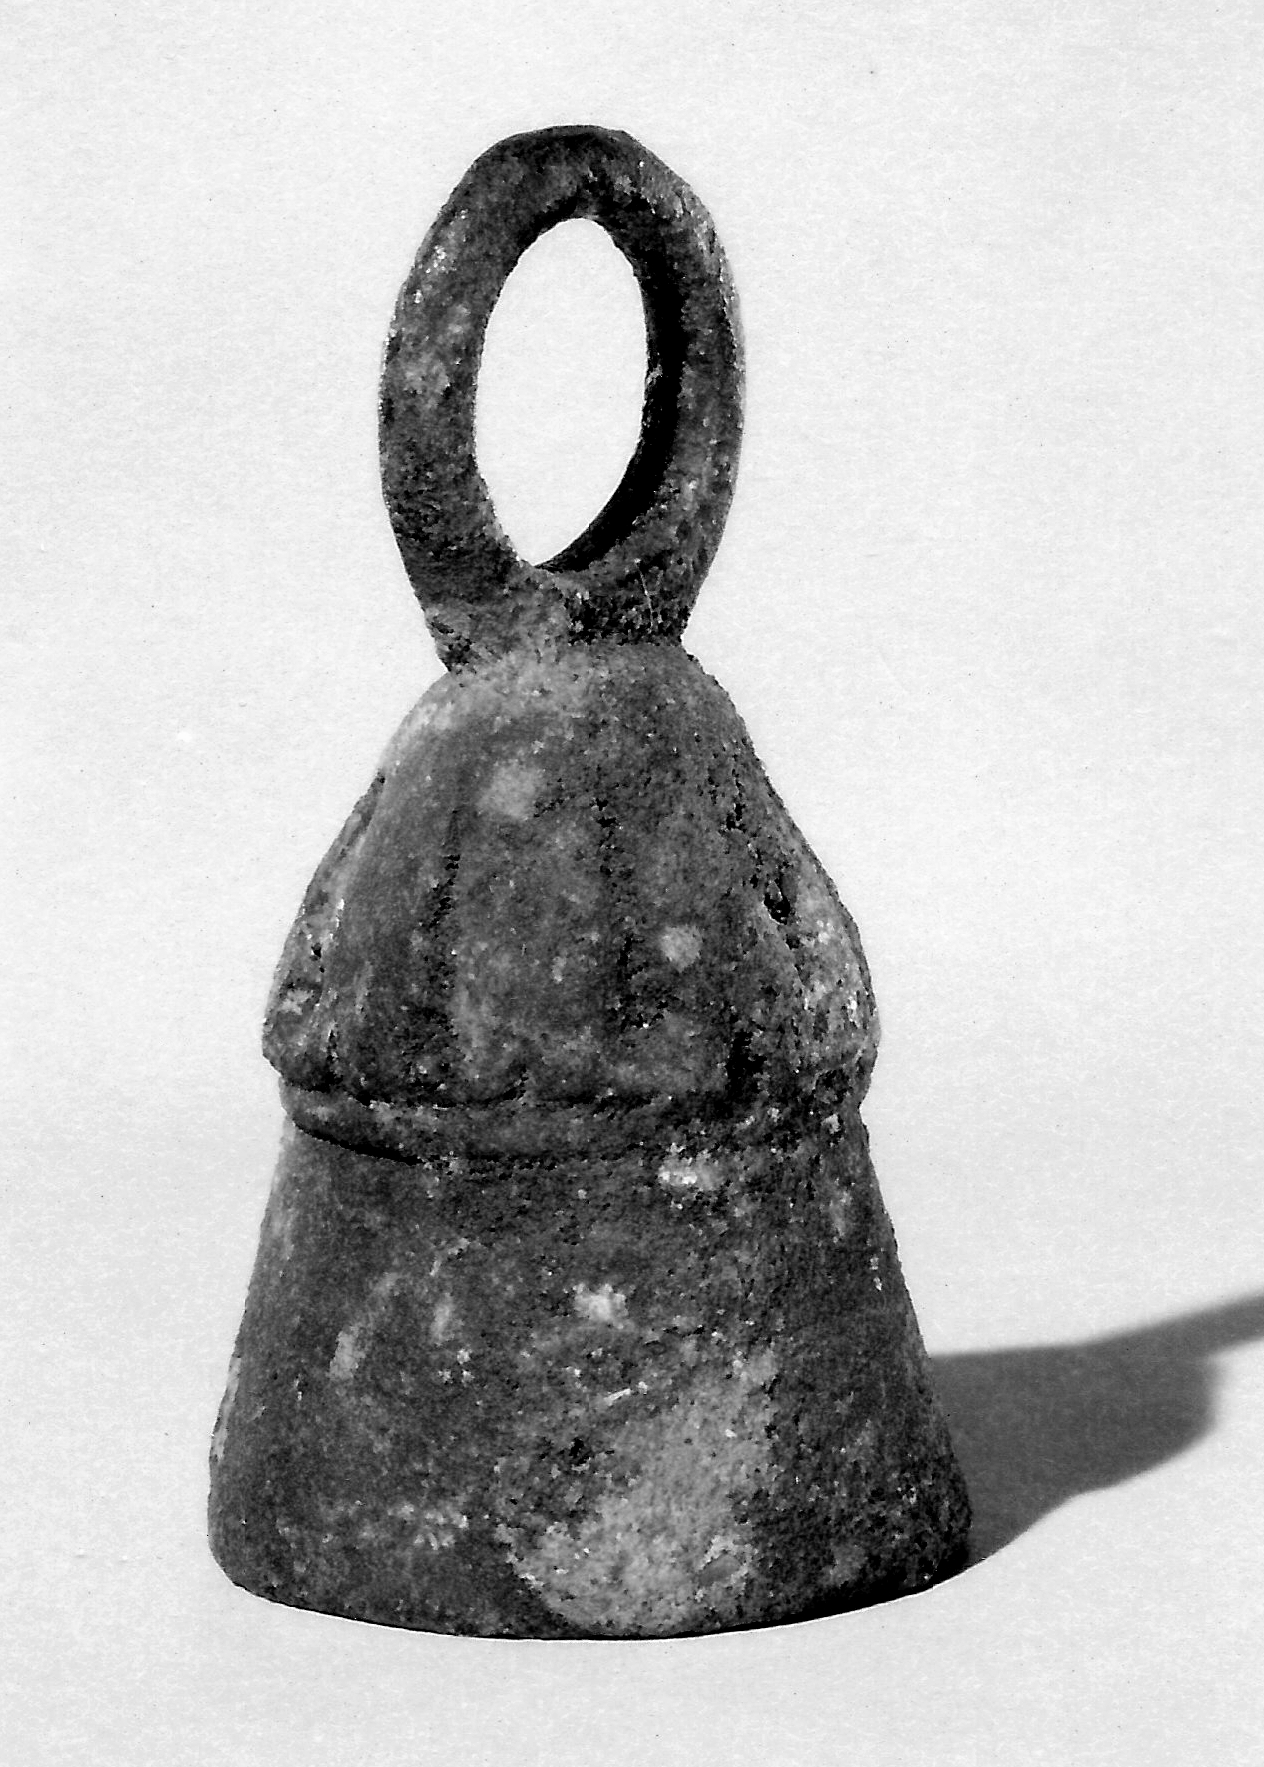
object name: bell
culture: italian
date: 1-33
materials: metal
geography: italy